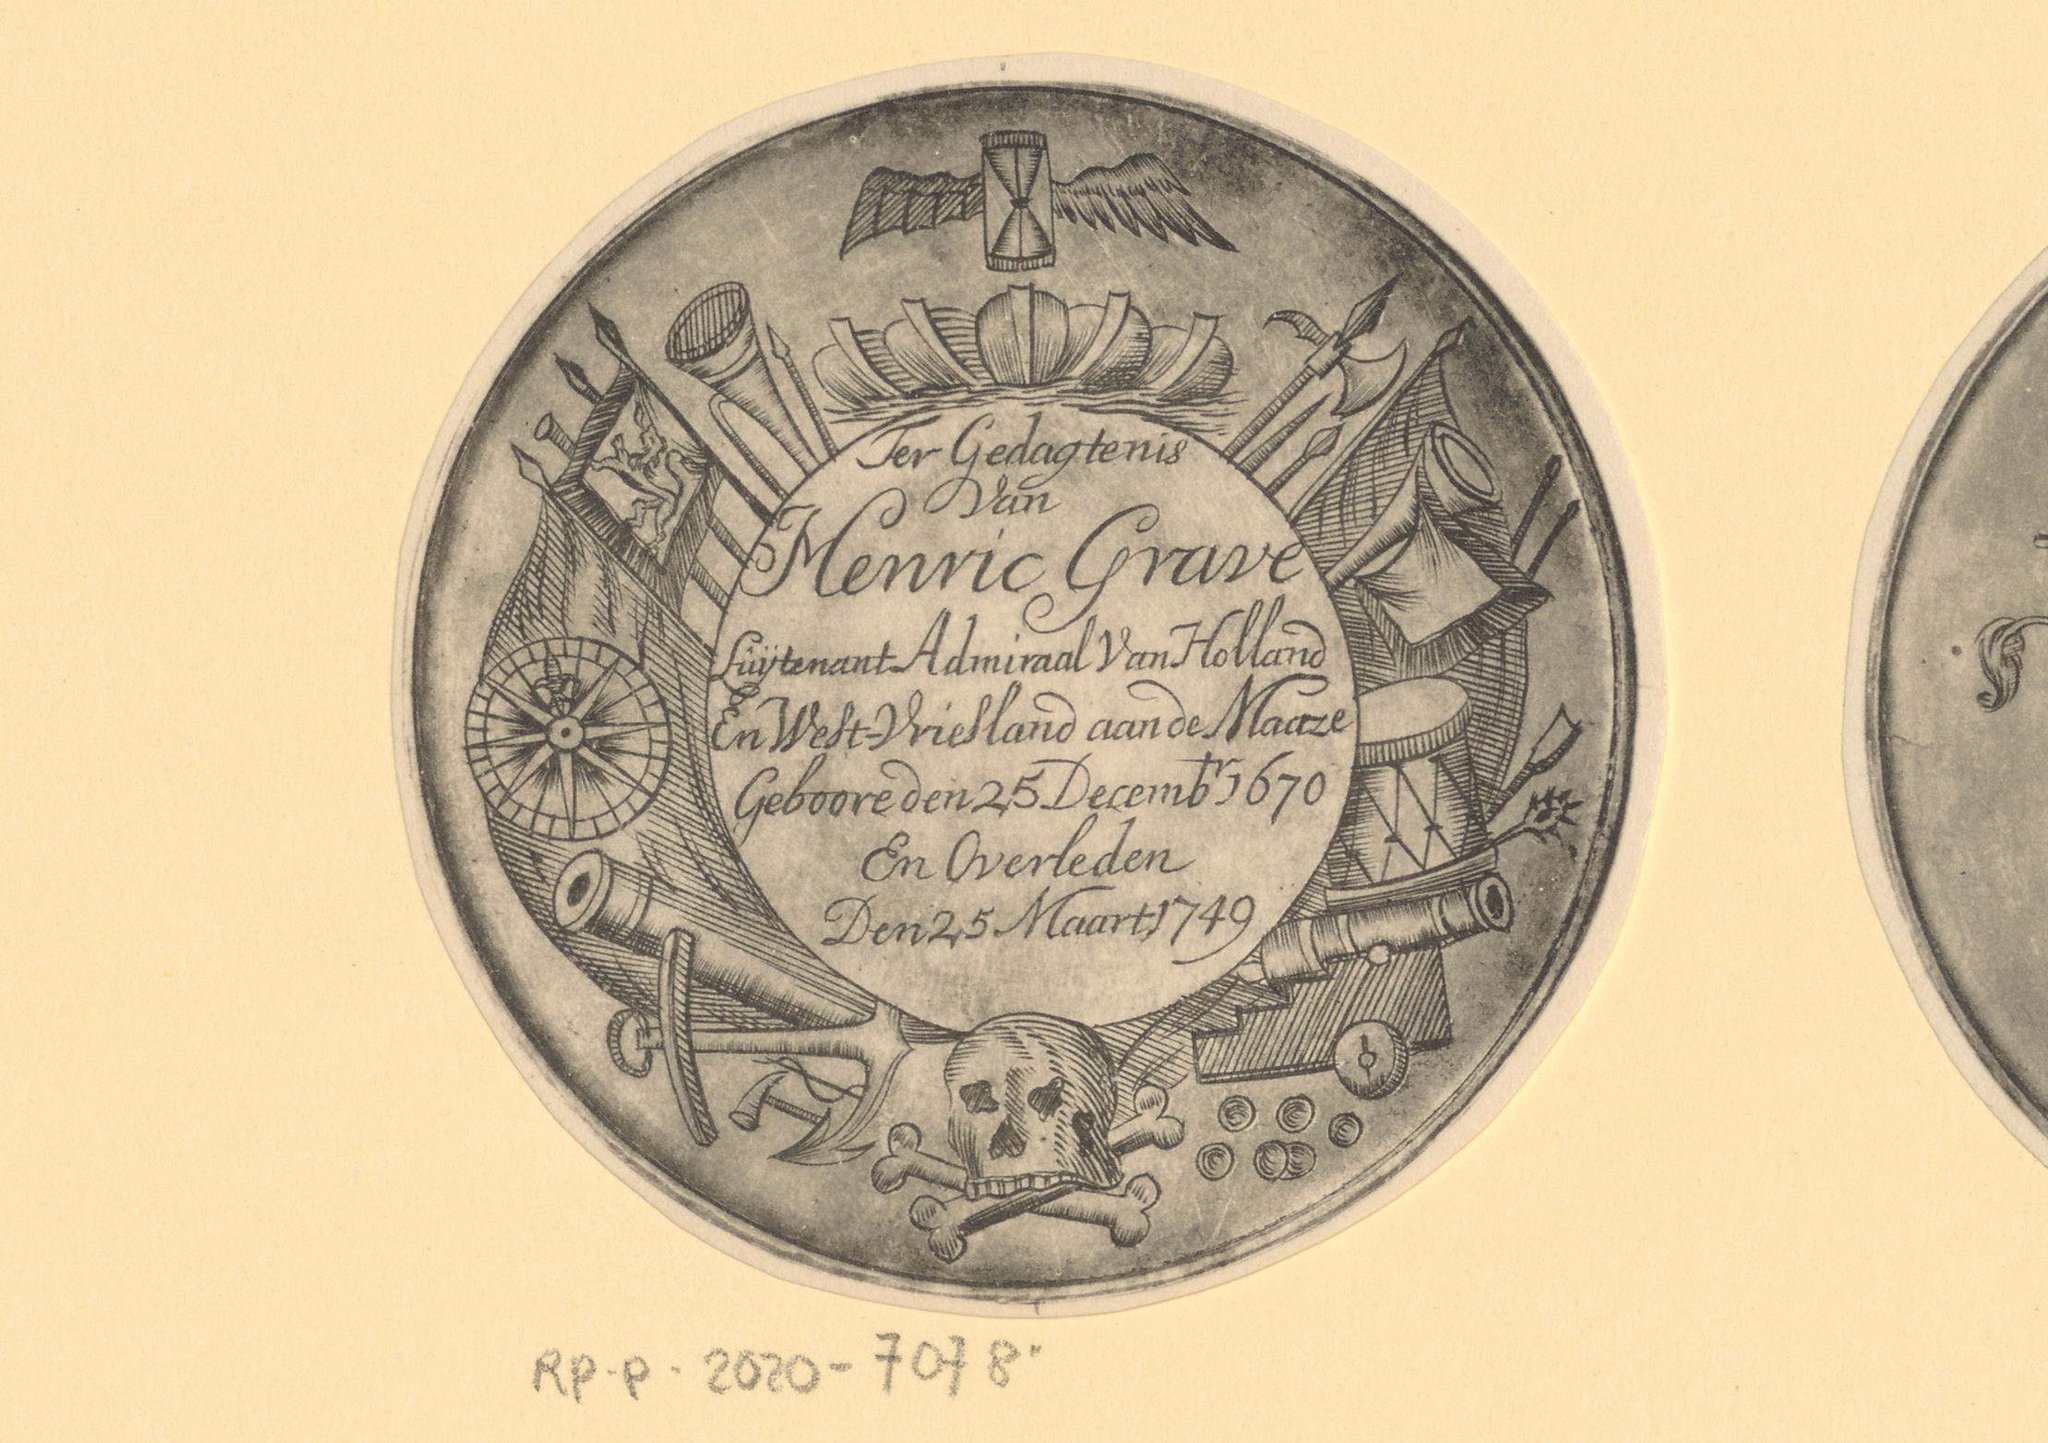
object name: photomechanical print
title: Ontwerp voor een gedenkpenning voor Hendrik Gravé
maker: Anonymous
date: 1900-1940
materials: paper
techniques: photograph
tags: amsterdam, commander-in-chief, general, marshal, historical persons, memorial medal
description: Tekst in het Nederlands in de ondermarge.